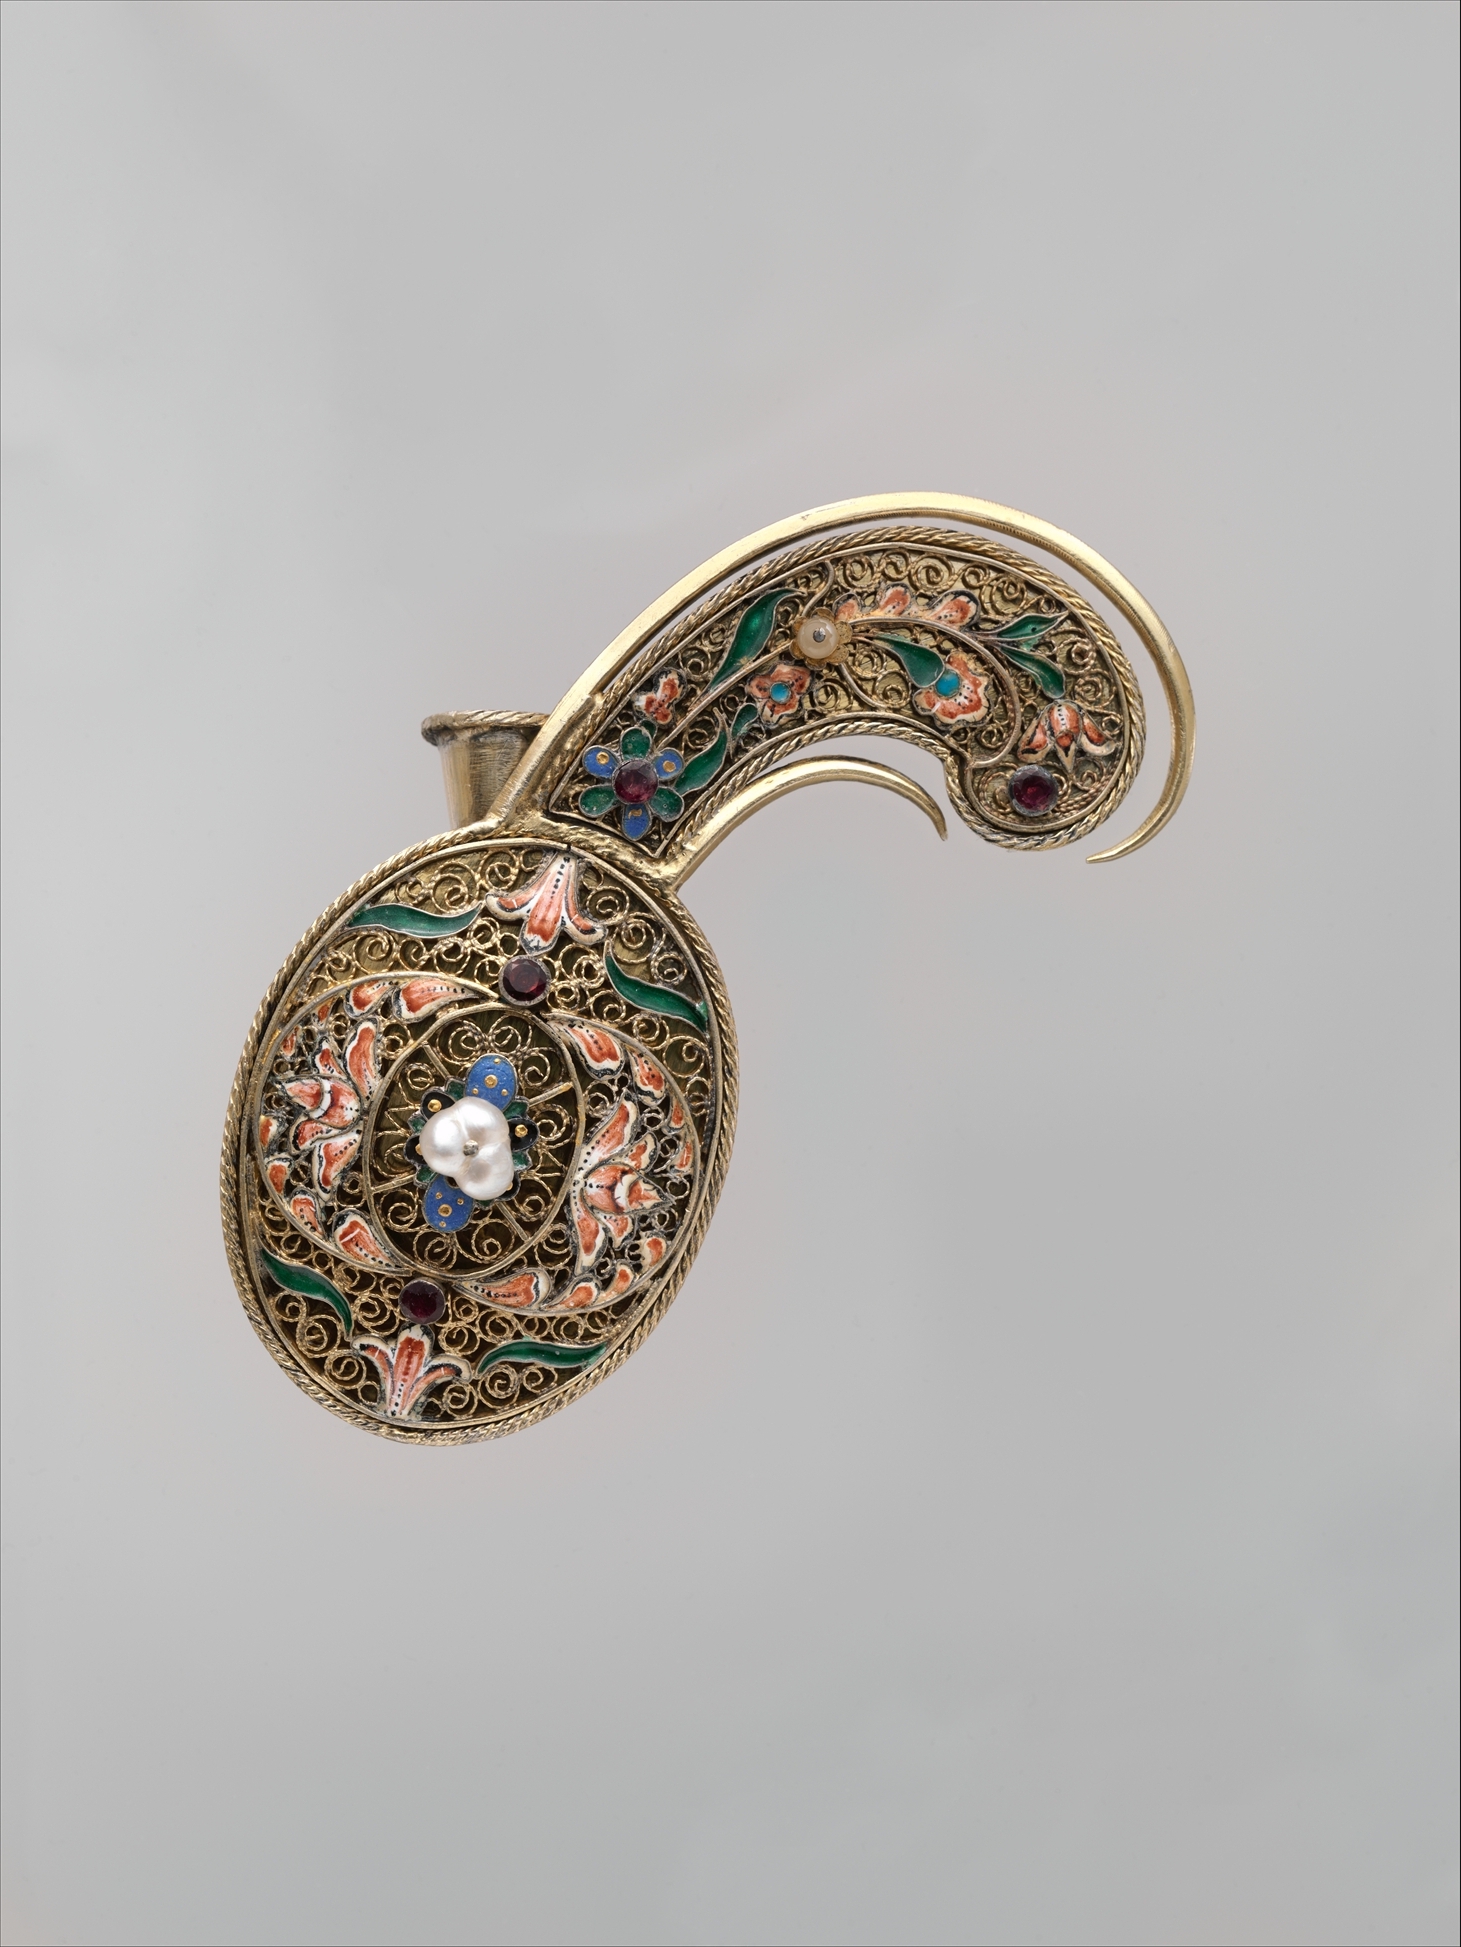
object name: turban ornament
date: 1801-1900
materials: enamel, glass, pearl, silver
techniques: filigree, gilding, inlay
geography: turkey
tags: flowers